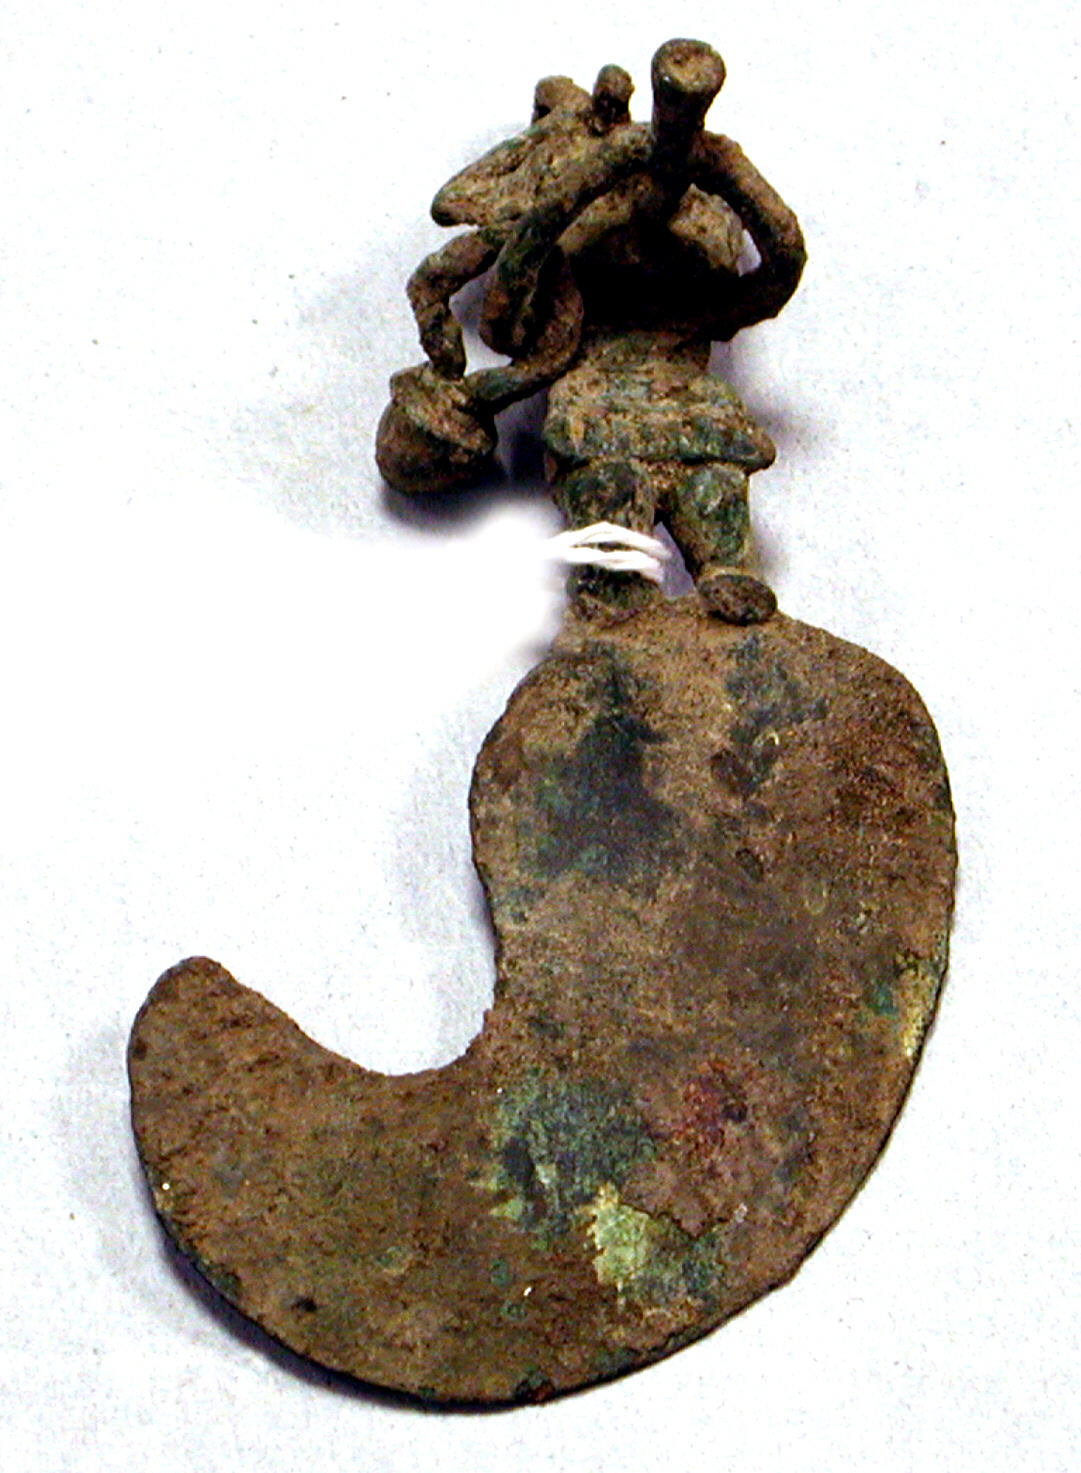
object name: knife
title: Ceremonial Knife (Tumi)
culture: chimú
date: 1101-1500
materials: copper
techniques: casting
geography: peru